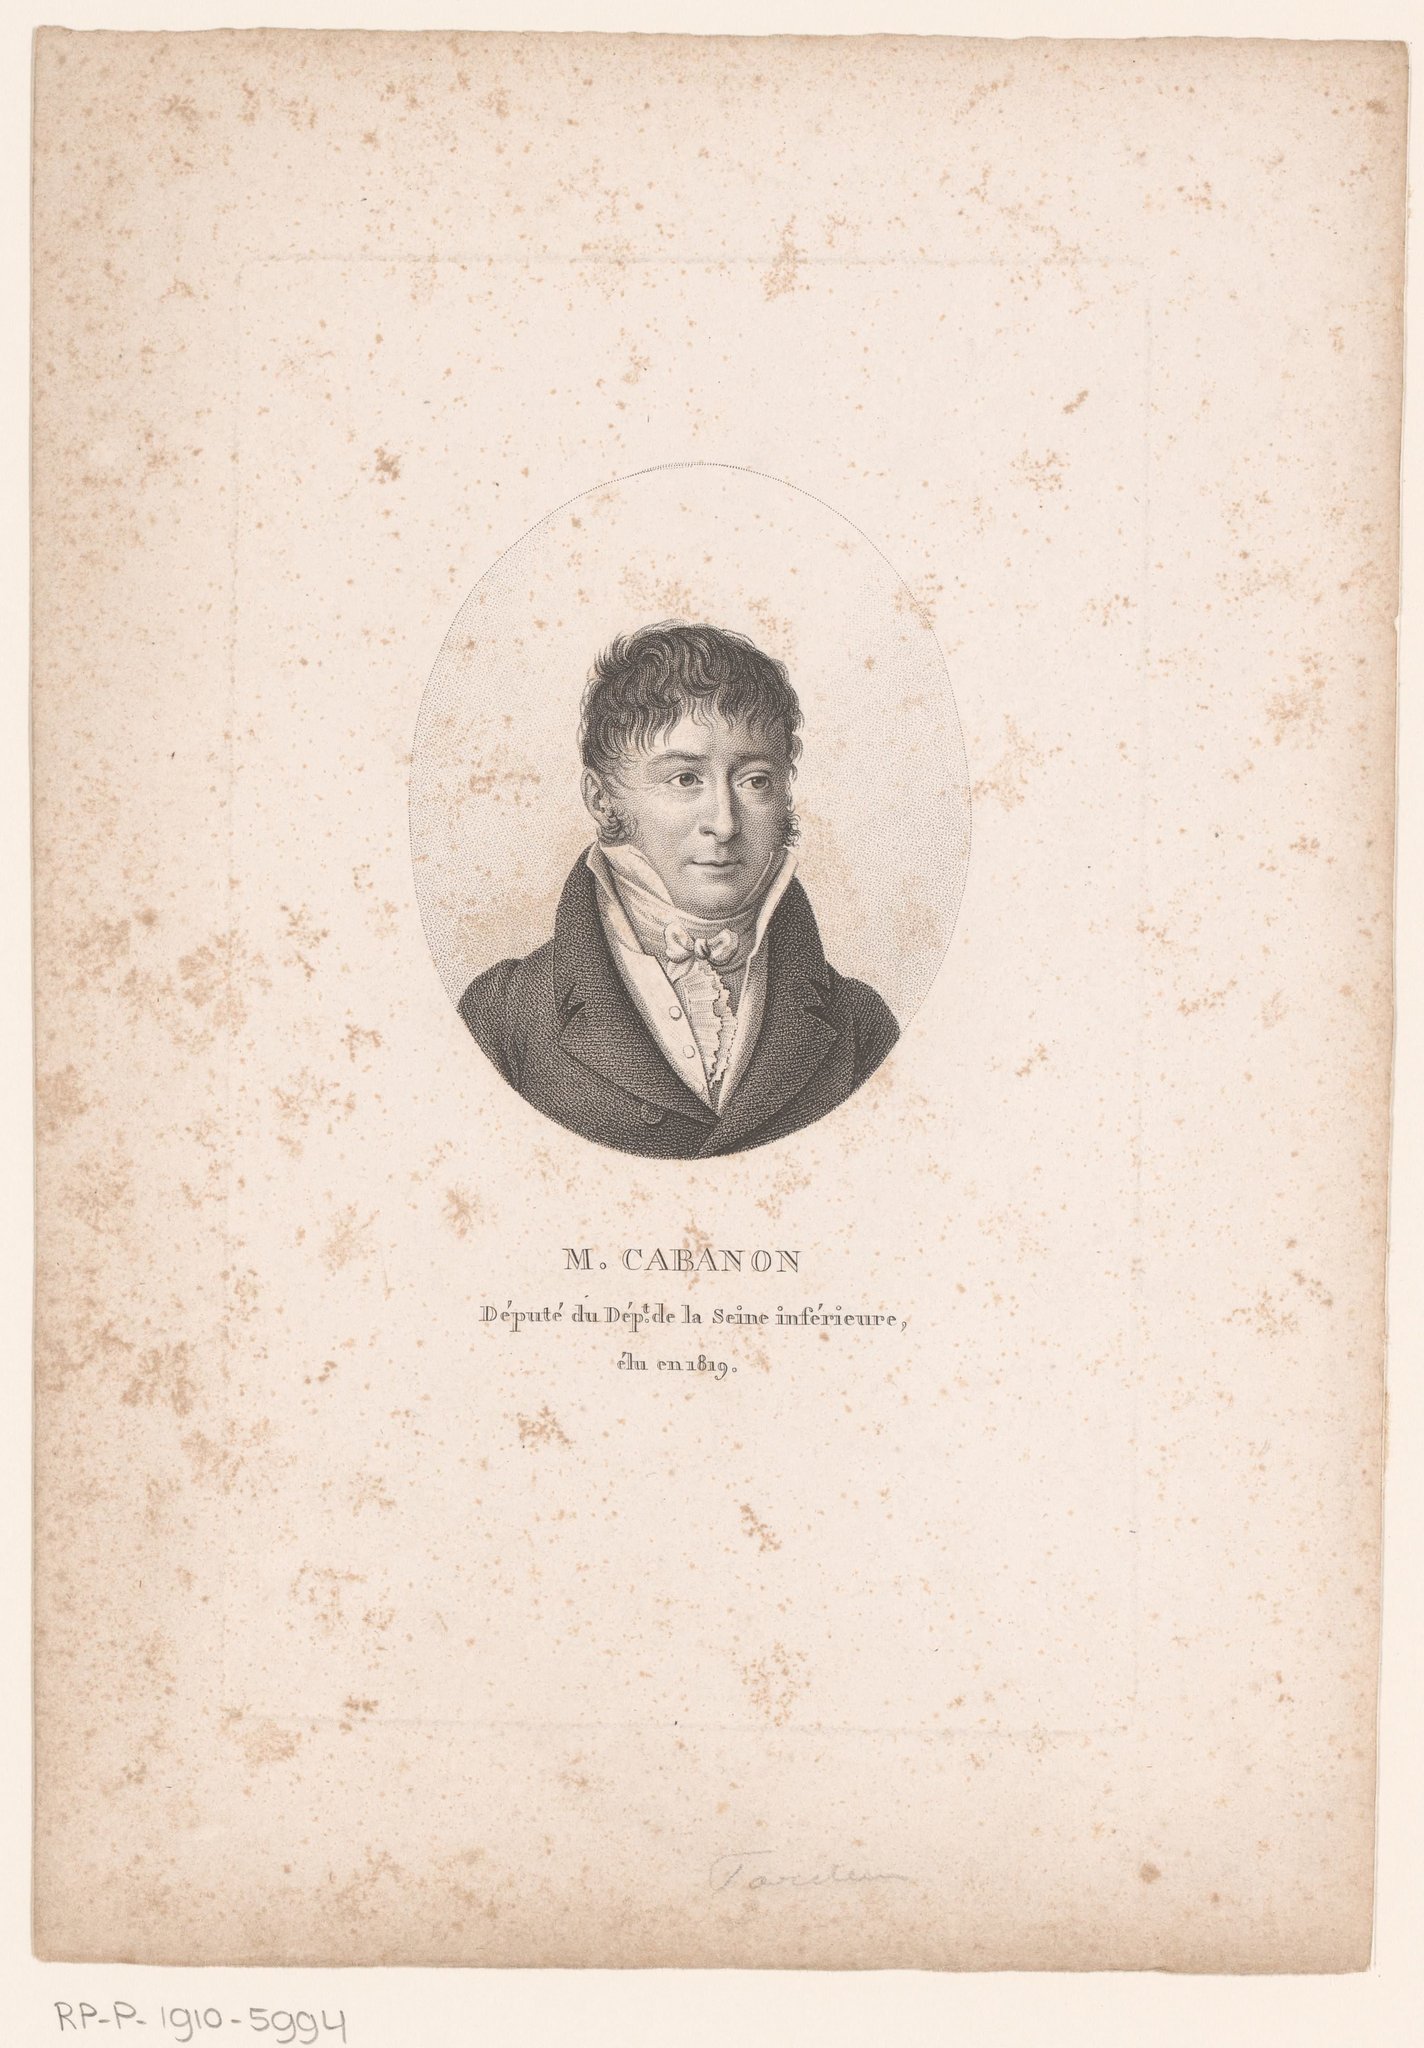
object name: book illustration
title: Portret van Bernard Cabanon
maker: ambroise tardieu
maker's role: print maker, printer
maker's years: 1788-1841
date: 1820-1821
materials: paper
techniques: engraving, roulette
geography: paris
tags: historical persons, politician, e.g. party leader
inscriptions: collector's mark: Lugt 2228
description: Prent uit: Tardieu, Ambroise. Portraits des députés, écrivains et pairs constitutionnels, défenseurs invariables de la charte et de la loi des élections du 5 février 1817. Parijs: Tardieu, Ambroise, 1820-1821.